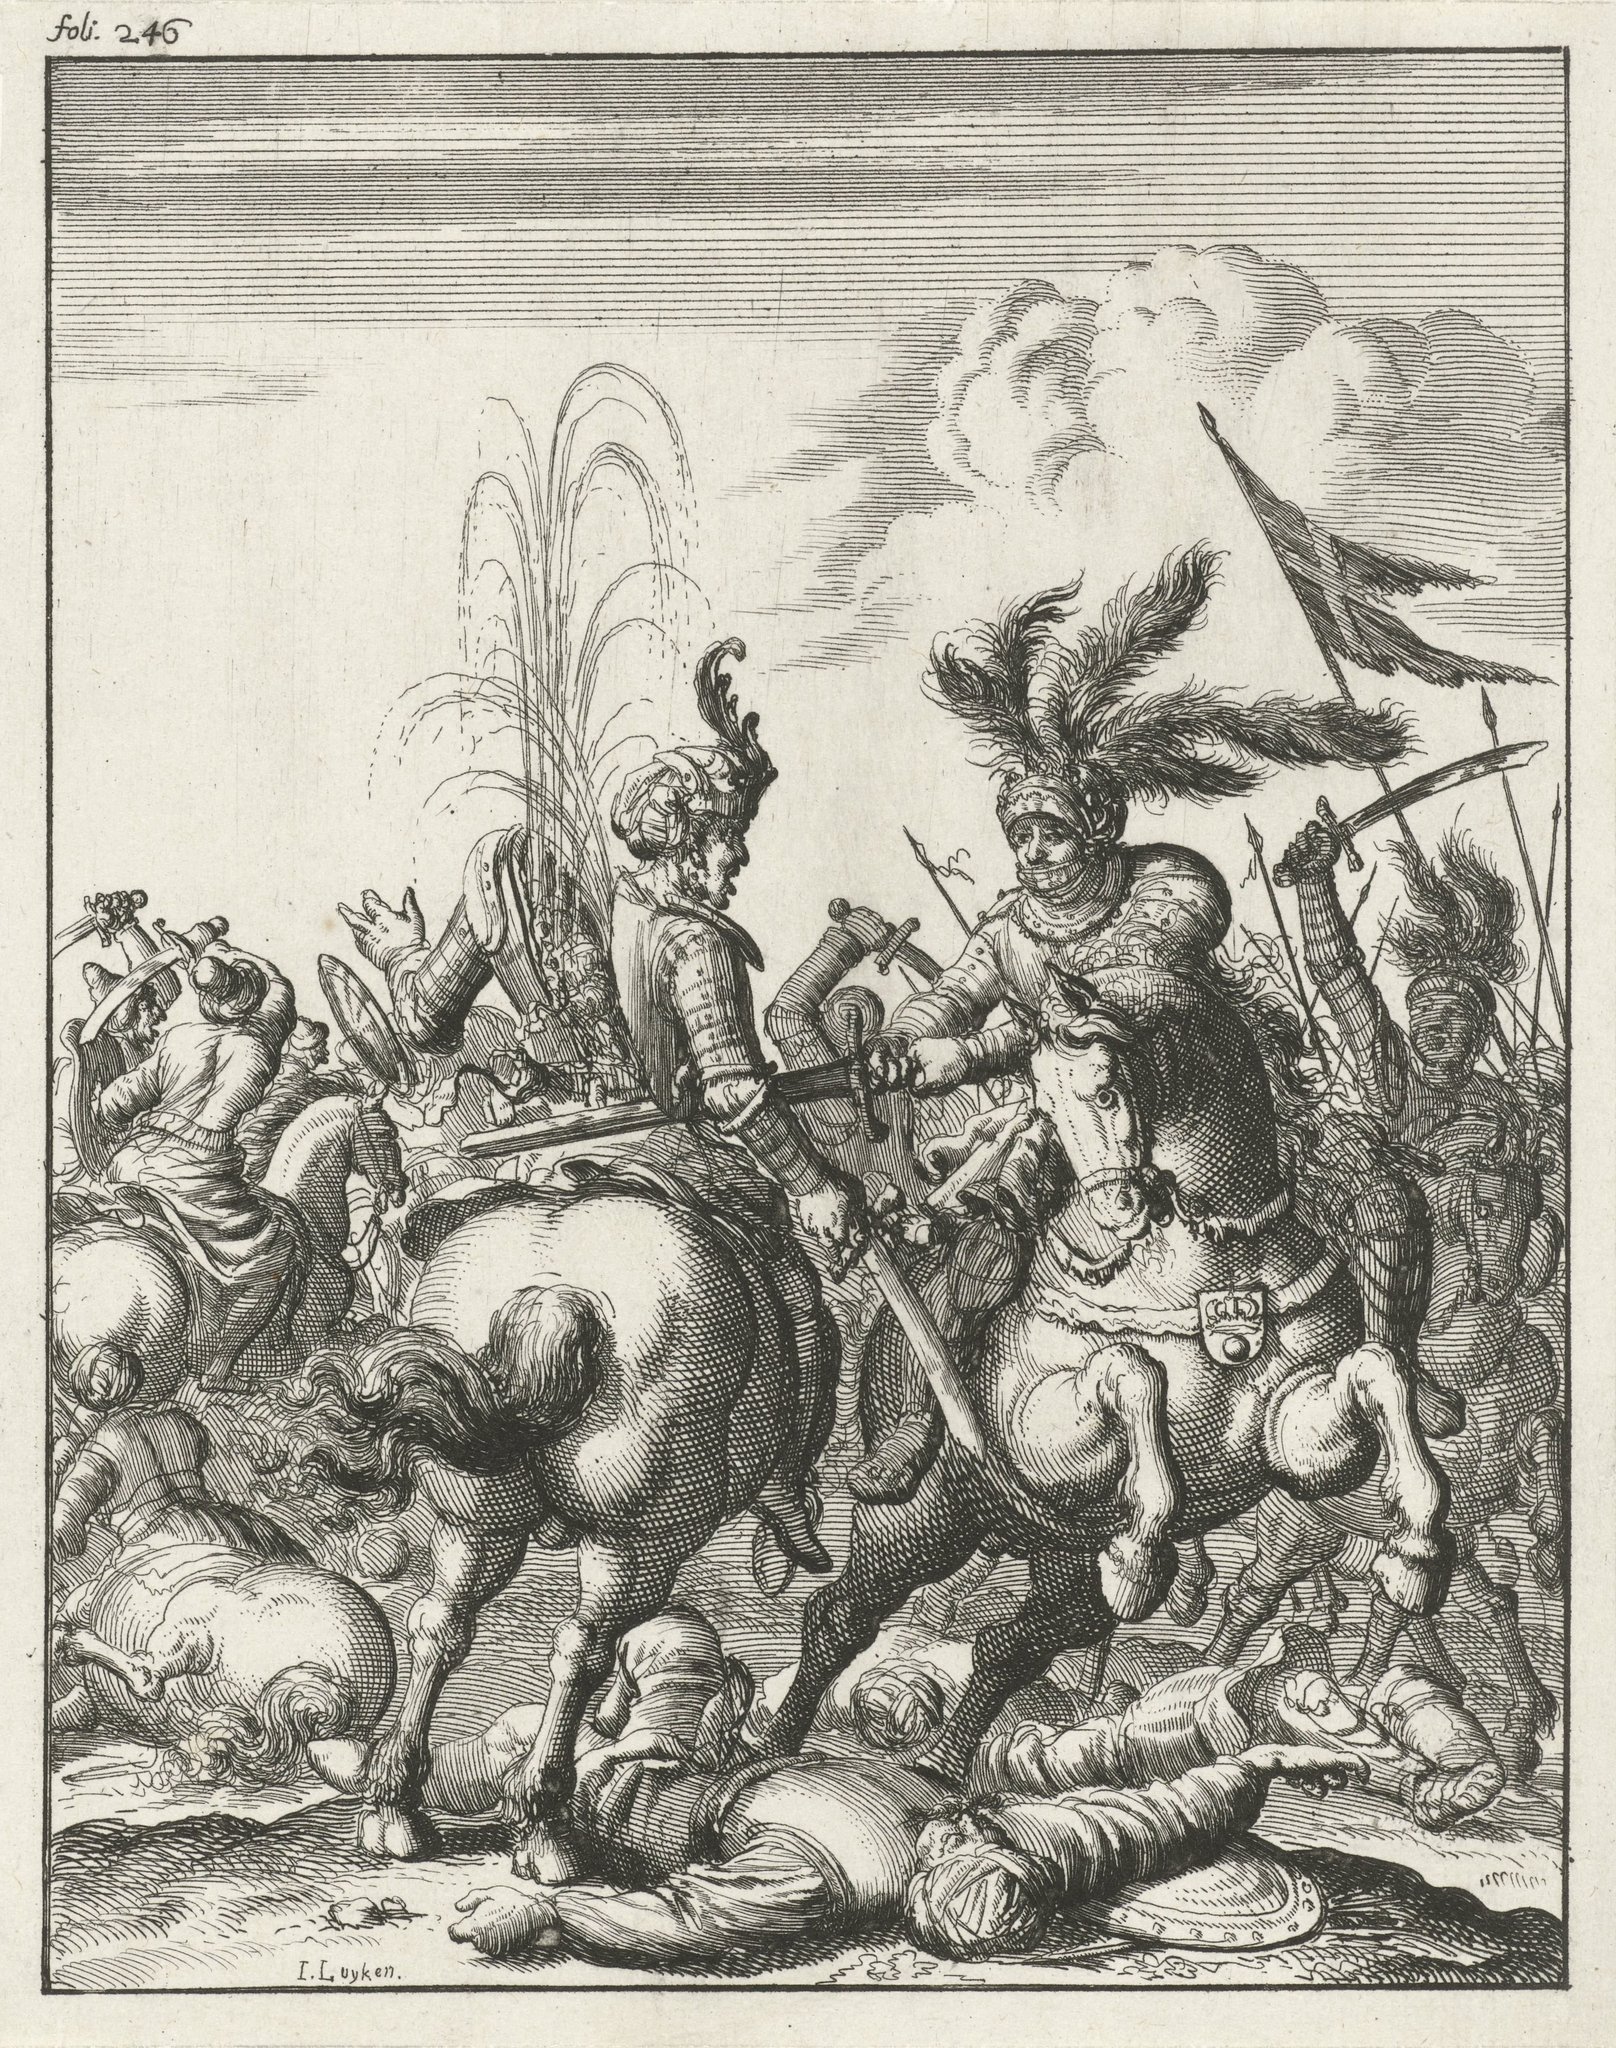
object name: print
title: Keizer Koenraad III doorklieft in een ruitergevecht een Saraceen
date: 1683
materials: paper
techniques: etching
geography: amsterdam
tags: battle, militant proselytizing: religious war, crusade, etc.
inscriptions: collector's mark: Lugt 2228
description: Illustratie opgenomen in: Maimbourg, Louis. Historie der kruisvaarders, tot de verlossing van't heilig land. Amsterdam: Timotheus ten Hoorn, 1683.